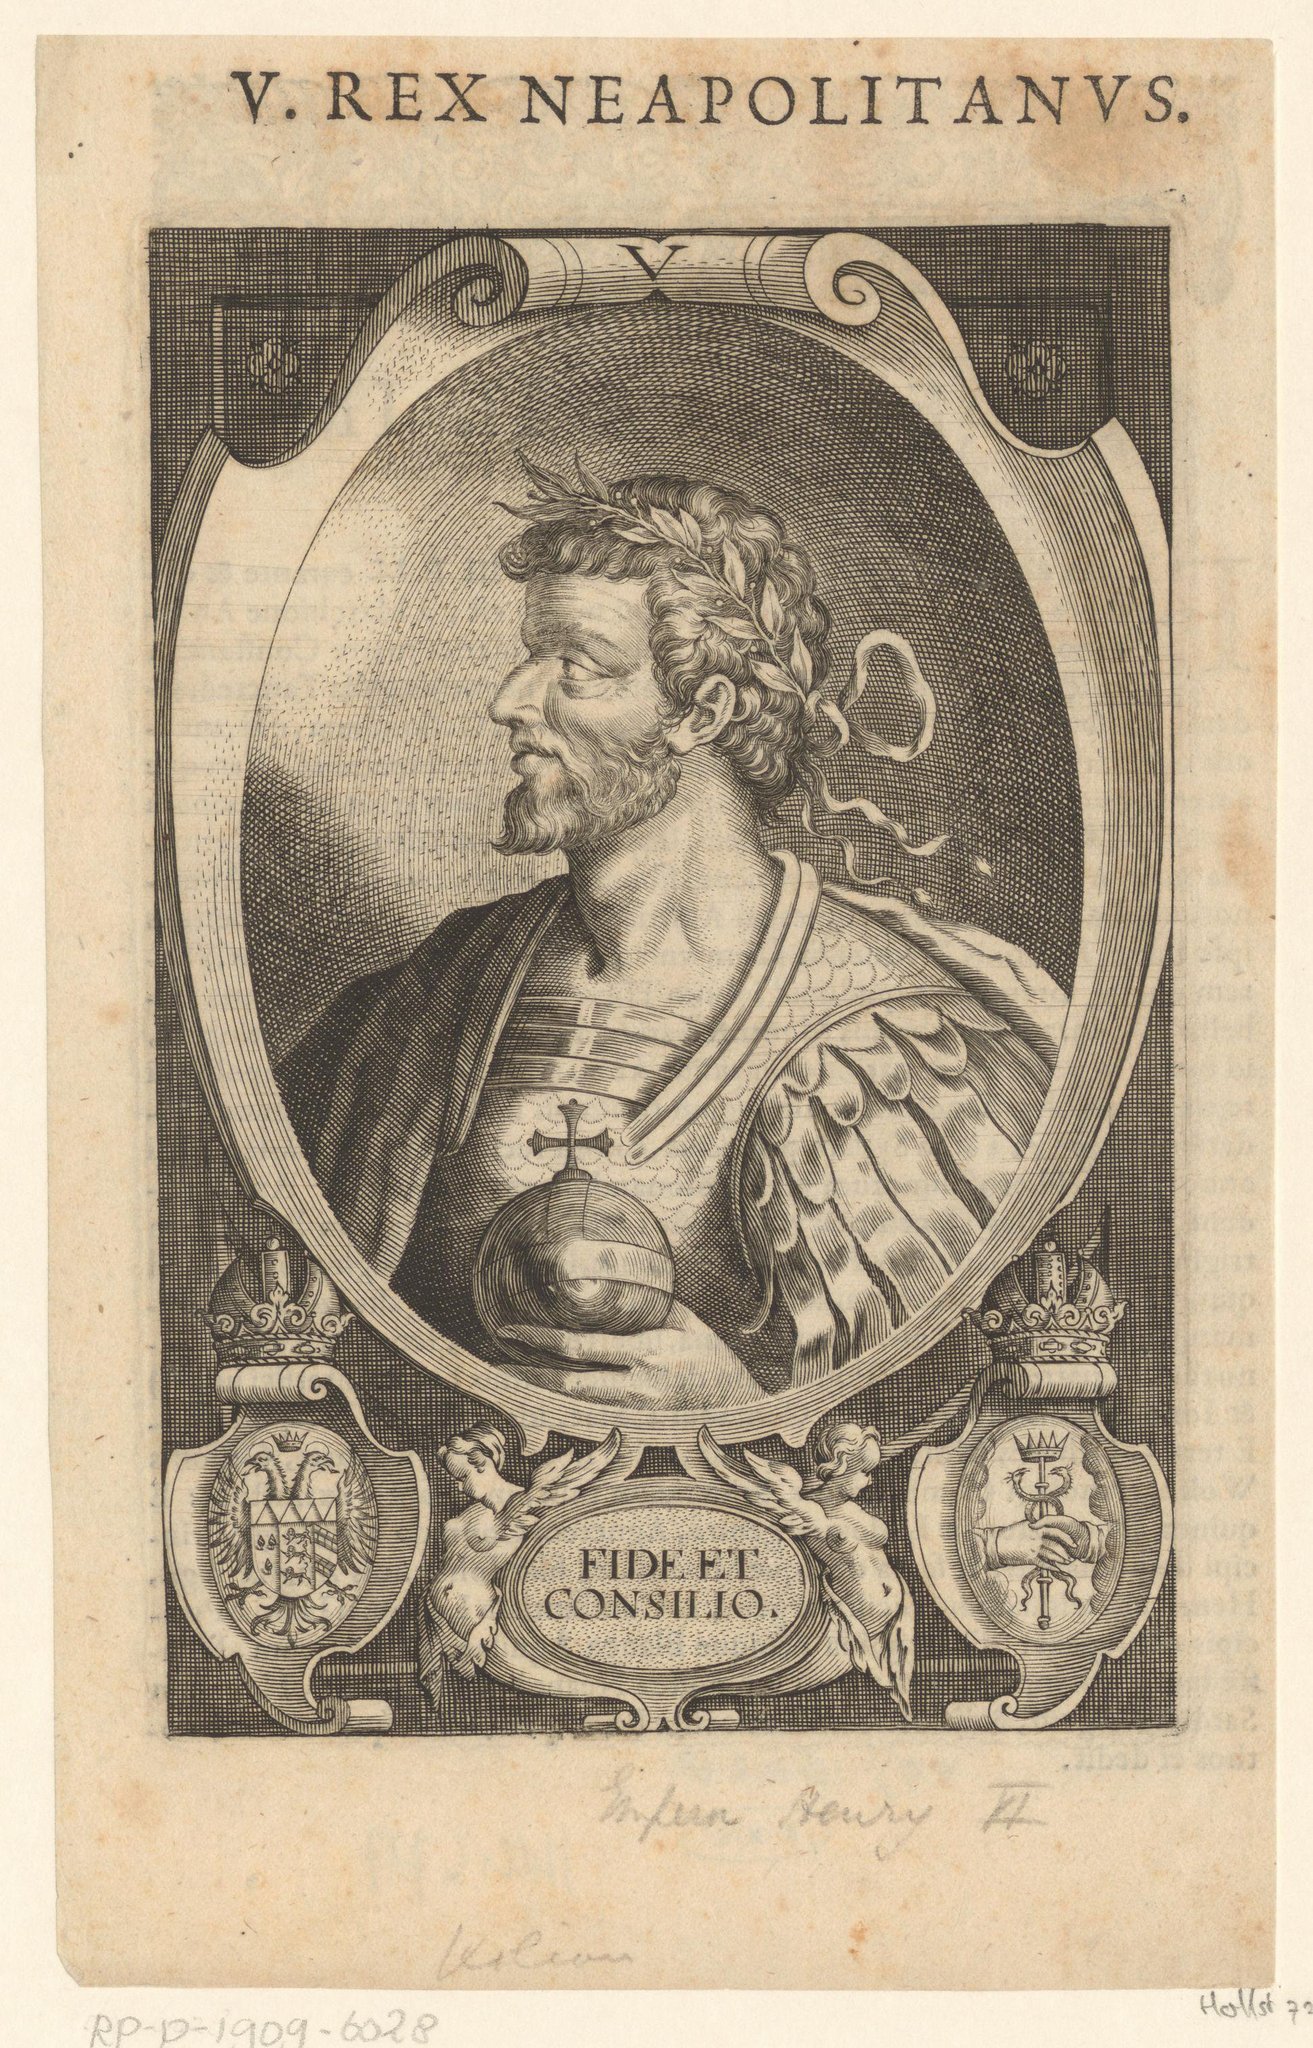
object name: book illustration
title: Portret van keizer Hendrik VI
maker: lucas kilian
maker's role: draughtsman, print maker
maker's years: 1579-1637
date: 1589-1624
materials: paper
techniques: engraving, etching, letterpress printing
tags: historical persons, ruler, sovereign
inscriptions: collector's mark: Lugt 2228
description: Deze prent is gebruikt in: Mazzella, Scipione, Kilian, Lucas en Custos, Dominicus. Der Neapolitanische Koenige Leben und Bildnisse (...). Augsburg: Lucas Kilian, 1624.